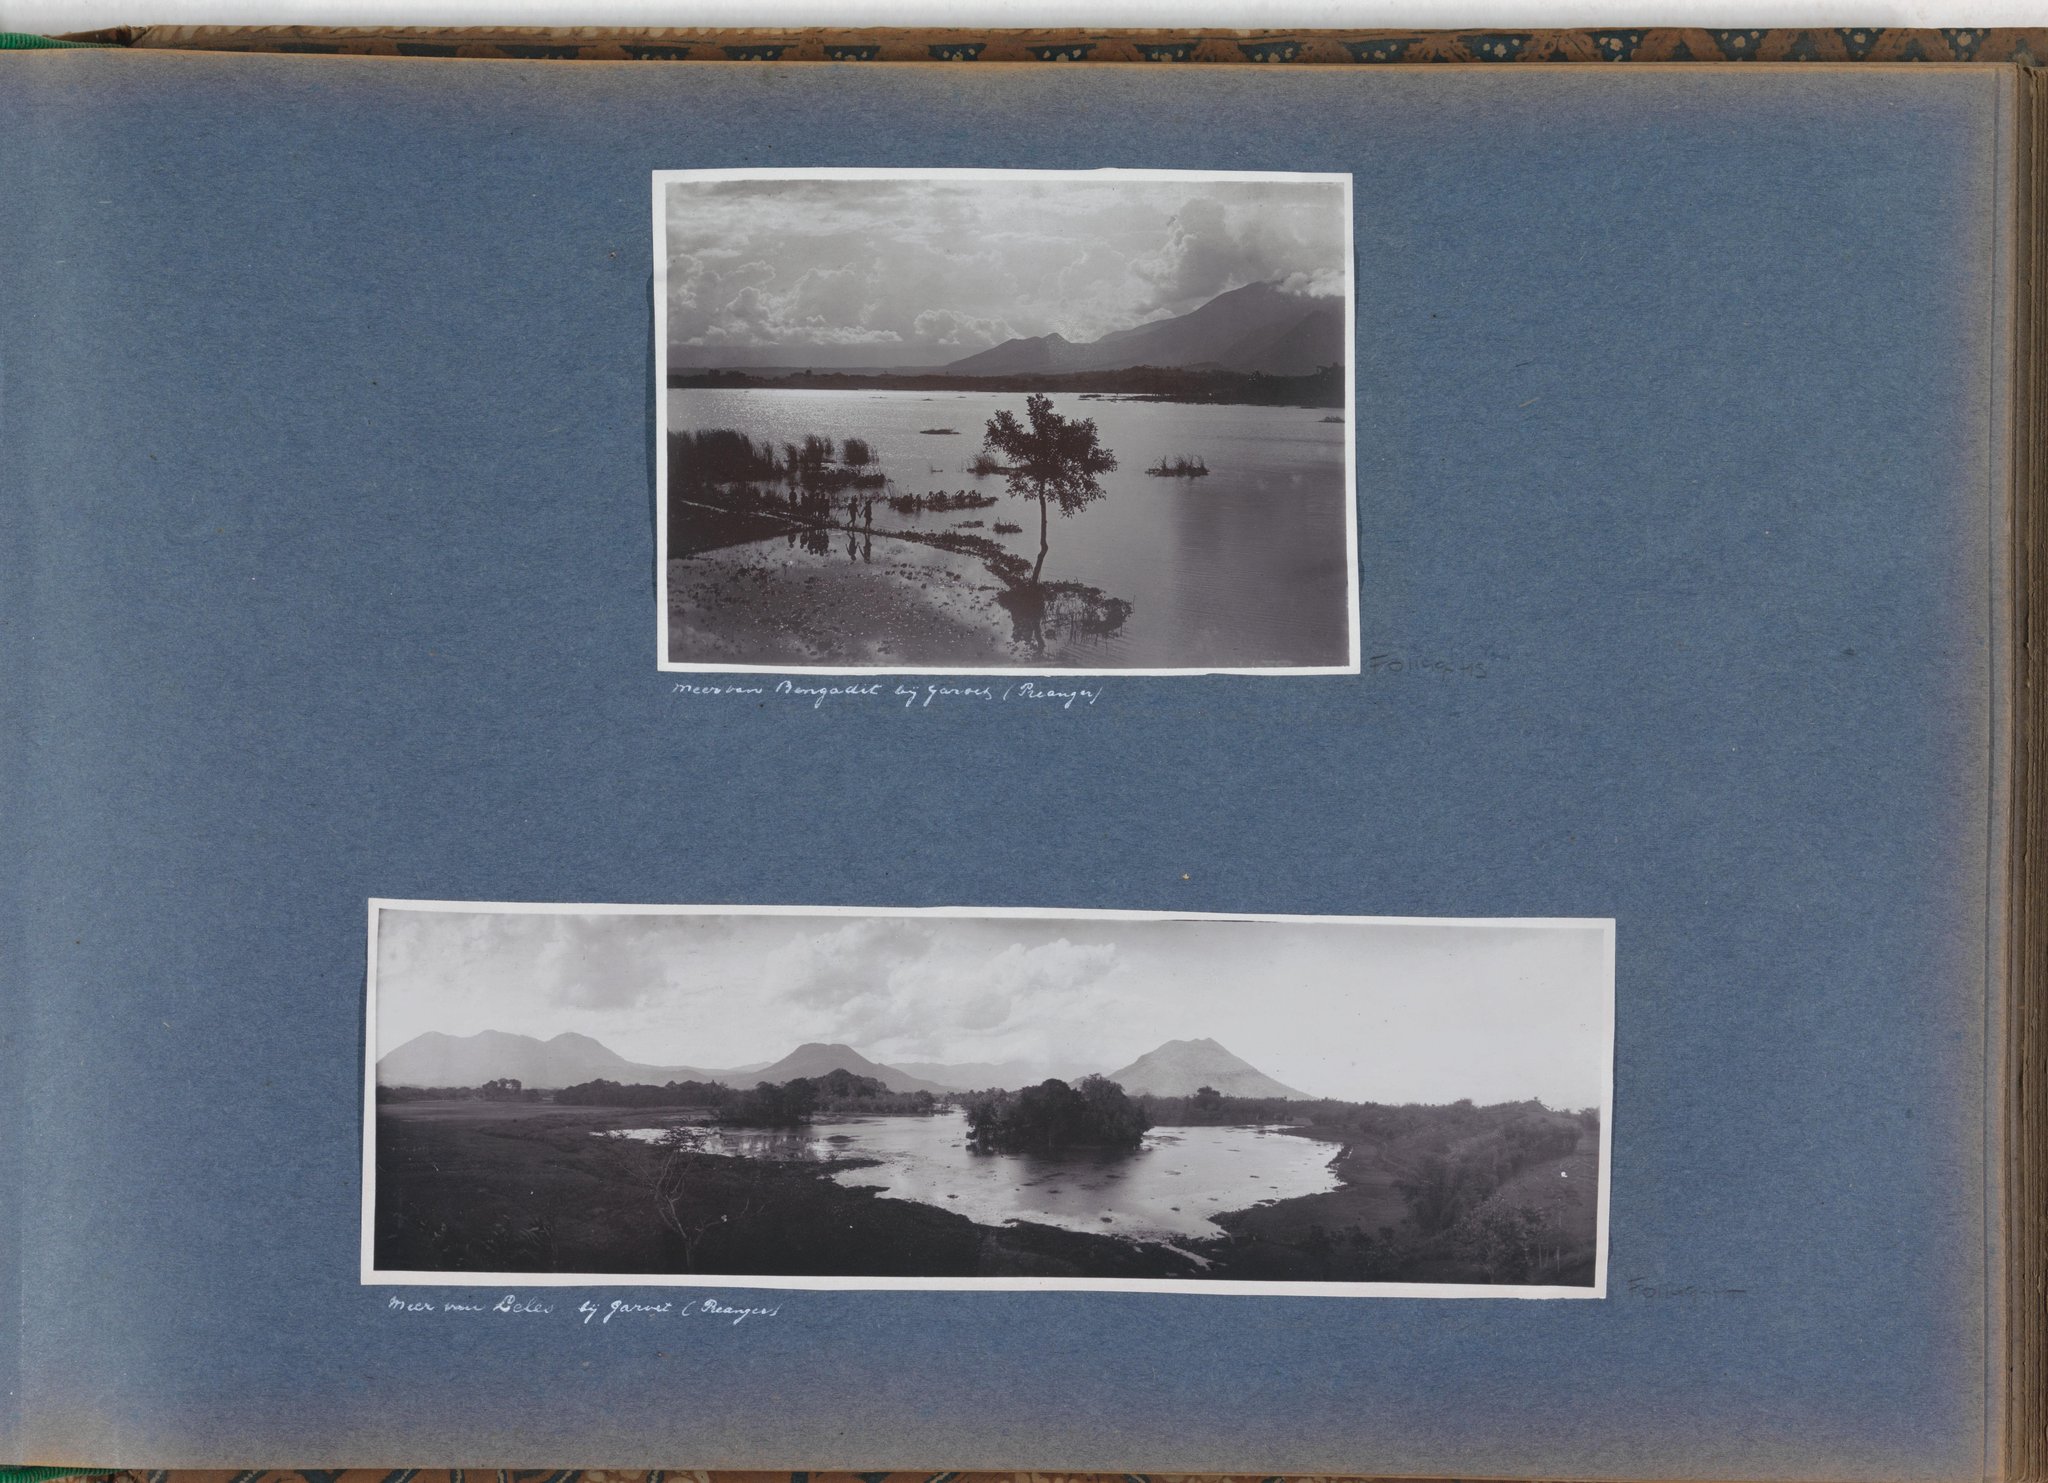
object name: photograph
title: Meer van Bengadit bij Garut in Preanger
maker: Anonymous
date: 1900-1920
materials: paper, photographic support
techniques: gelatin silver print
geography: garut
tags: lake, mountains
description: Onderdeel van reisalbum met foto's van bedrijvigheid en bezienswaardigheden op Sumatra en Java en van de reis naar en van Nederlands-Indië.